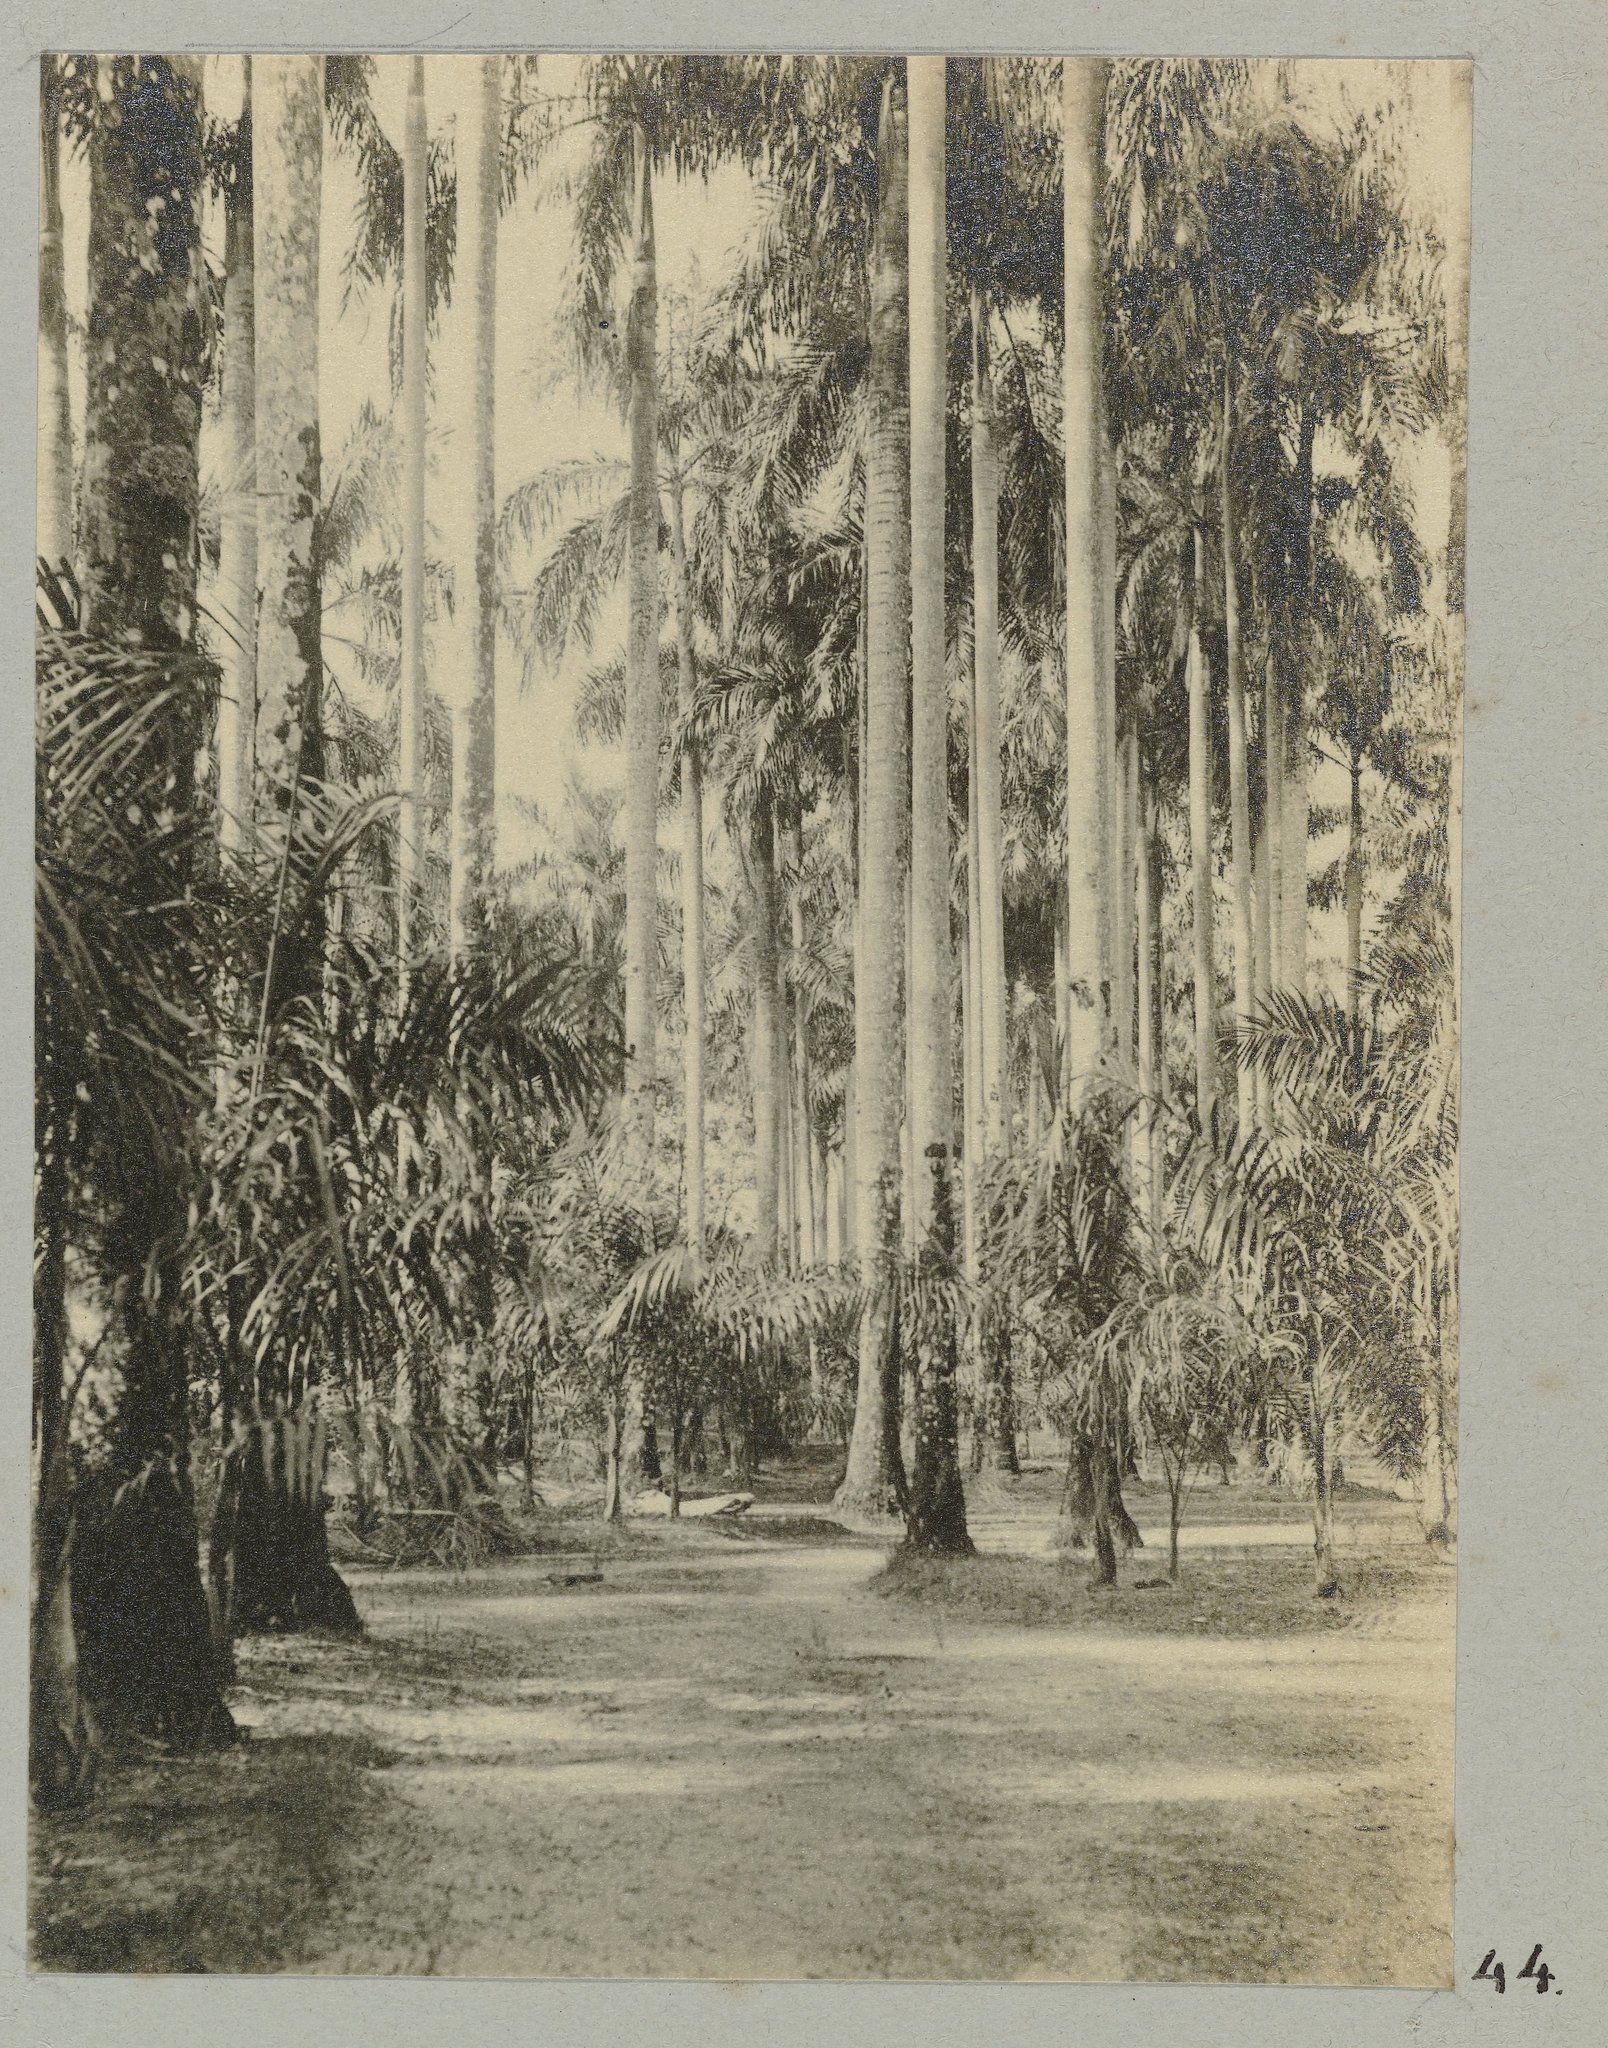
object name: photograph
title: Palmentuin, Paramaribo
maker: hendrik doijer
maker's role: engineer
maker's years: 1863-1925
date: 1903-1910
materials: photographic support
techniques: gelatin silver print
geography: suriname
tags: suriname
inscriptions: inscription: ‘43. / Palmentuin, Paramaribo’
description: Hoge bomen in de Palmentuin te Paramaribo. Onderdeel van het fotoalbum Souvenir de Voyage (deel 2), over het leven van de familie Doijer in en rond de plantage Ma Retraite in Suriname in de jaren 1903-1910.